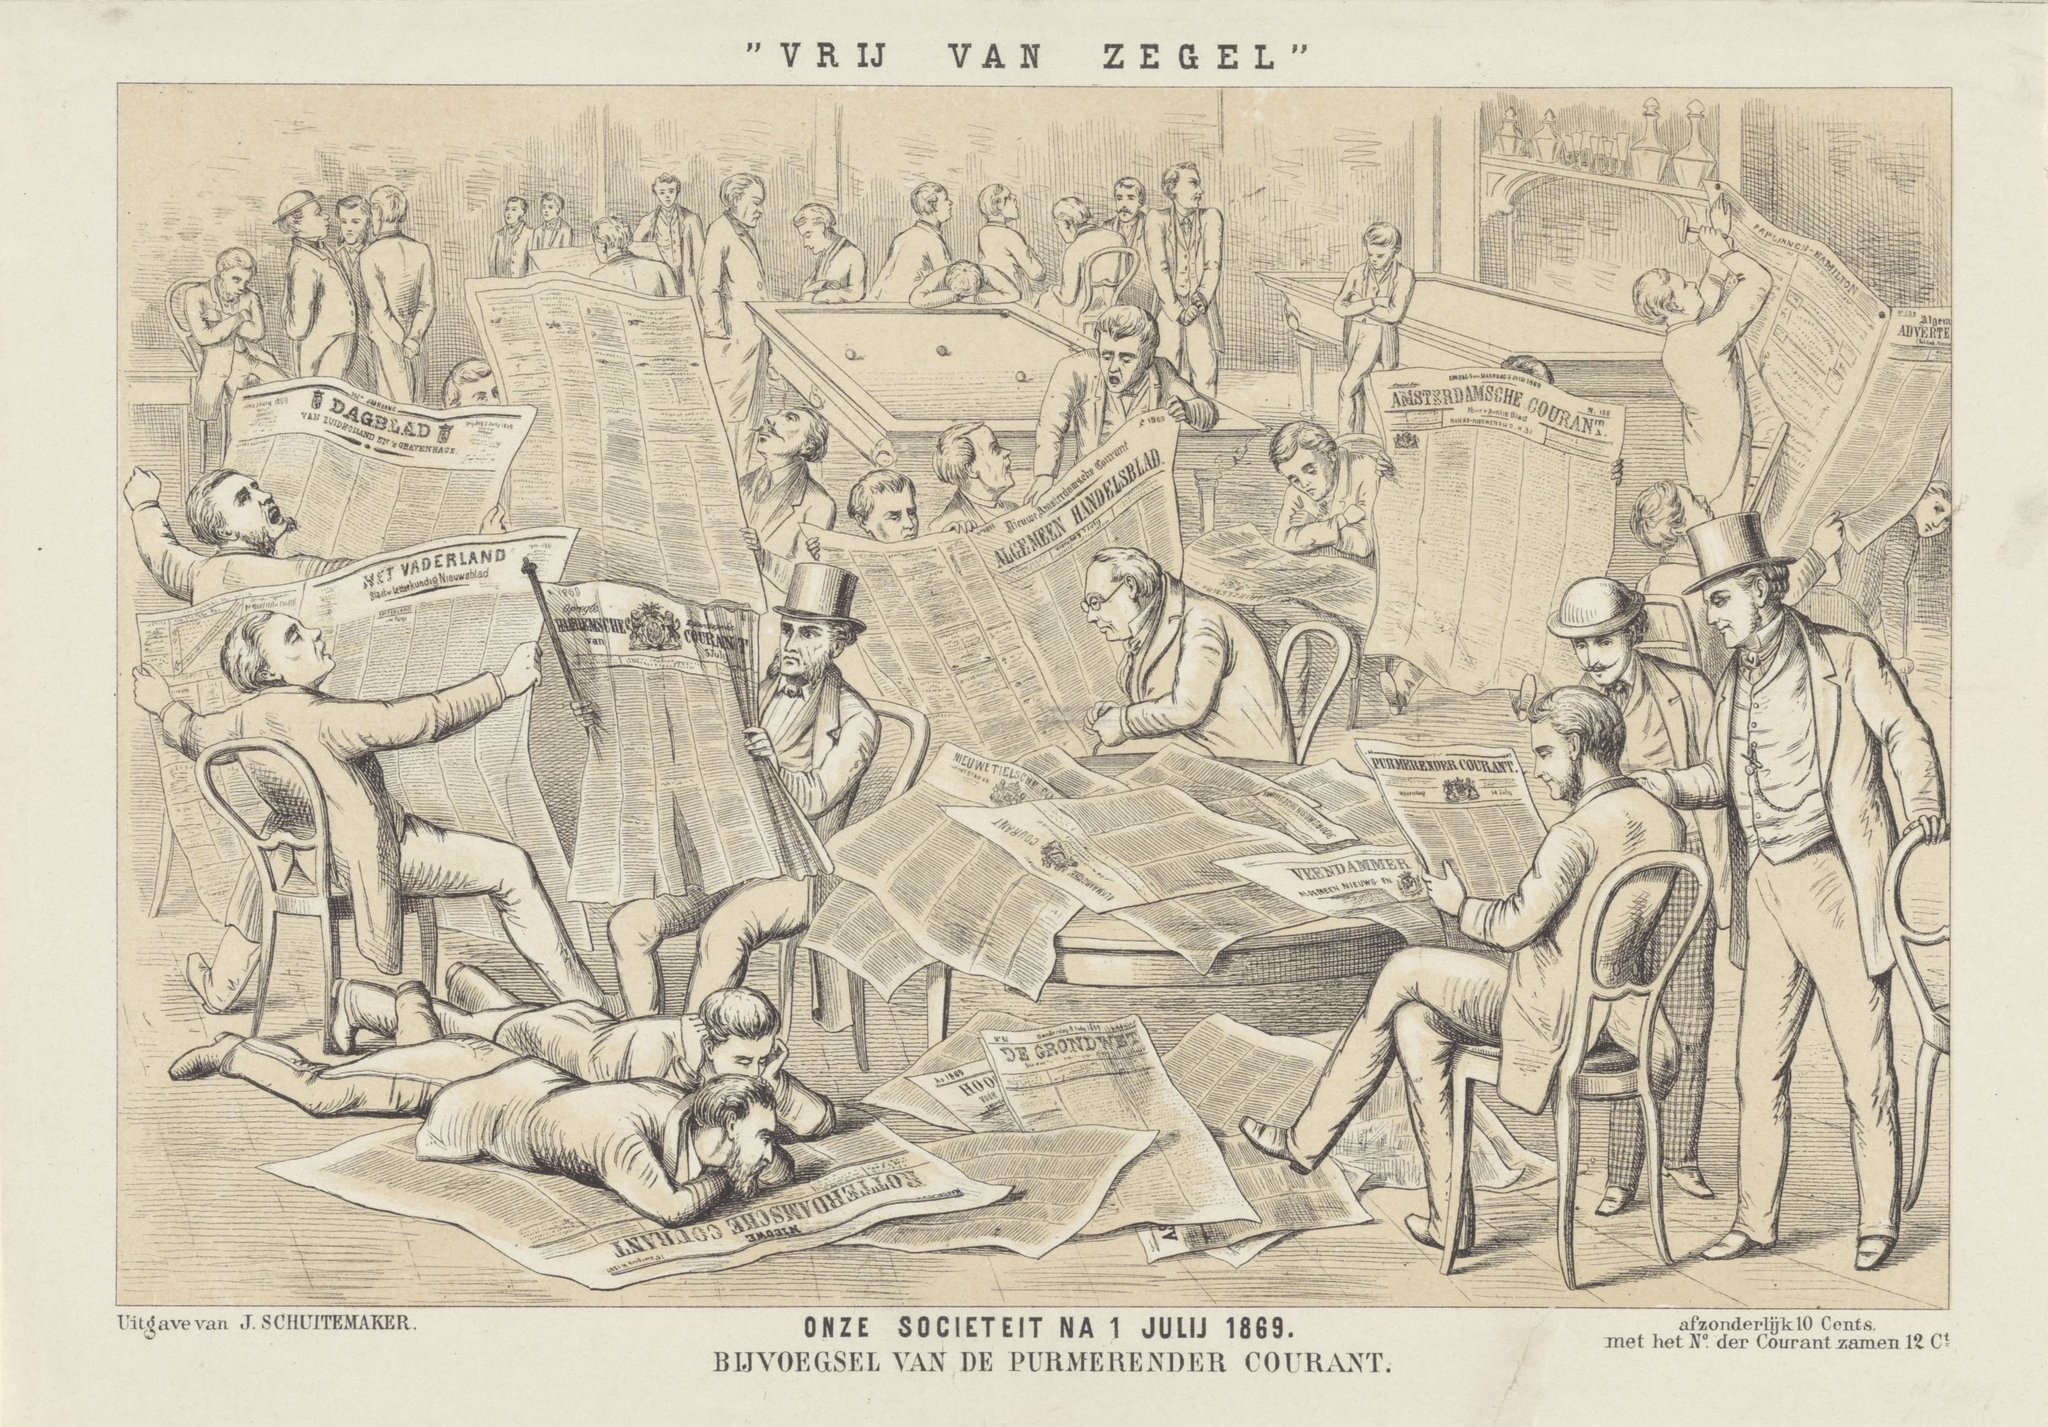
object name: print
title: "Vrij van Zegel" / Onze societeit na 1 julij 1869. Bijvoegsel van de Purmerender Courant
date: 1869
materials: paper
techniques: tone lithography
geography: netherlands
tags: club, meeting place, reading, newspaper, news-sheet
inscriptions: collector's mark: Lugt 2228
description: Spotprent op het groter worden van de meeste dagbladen na de afschaffing van het zegelrecht op 1 juli 1869. Gezicht in de leeskamer van een sociëteit waar de leden worstelen met het grote formaat van de kranten. Gepubliceerd als bijlage bij de Purmerender Courant van 8 augustus 1869, een krant die het oude kleinere formaat heeft gehouden. Zie de bijbehorende krant.